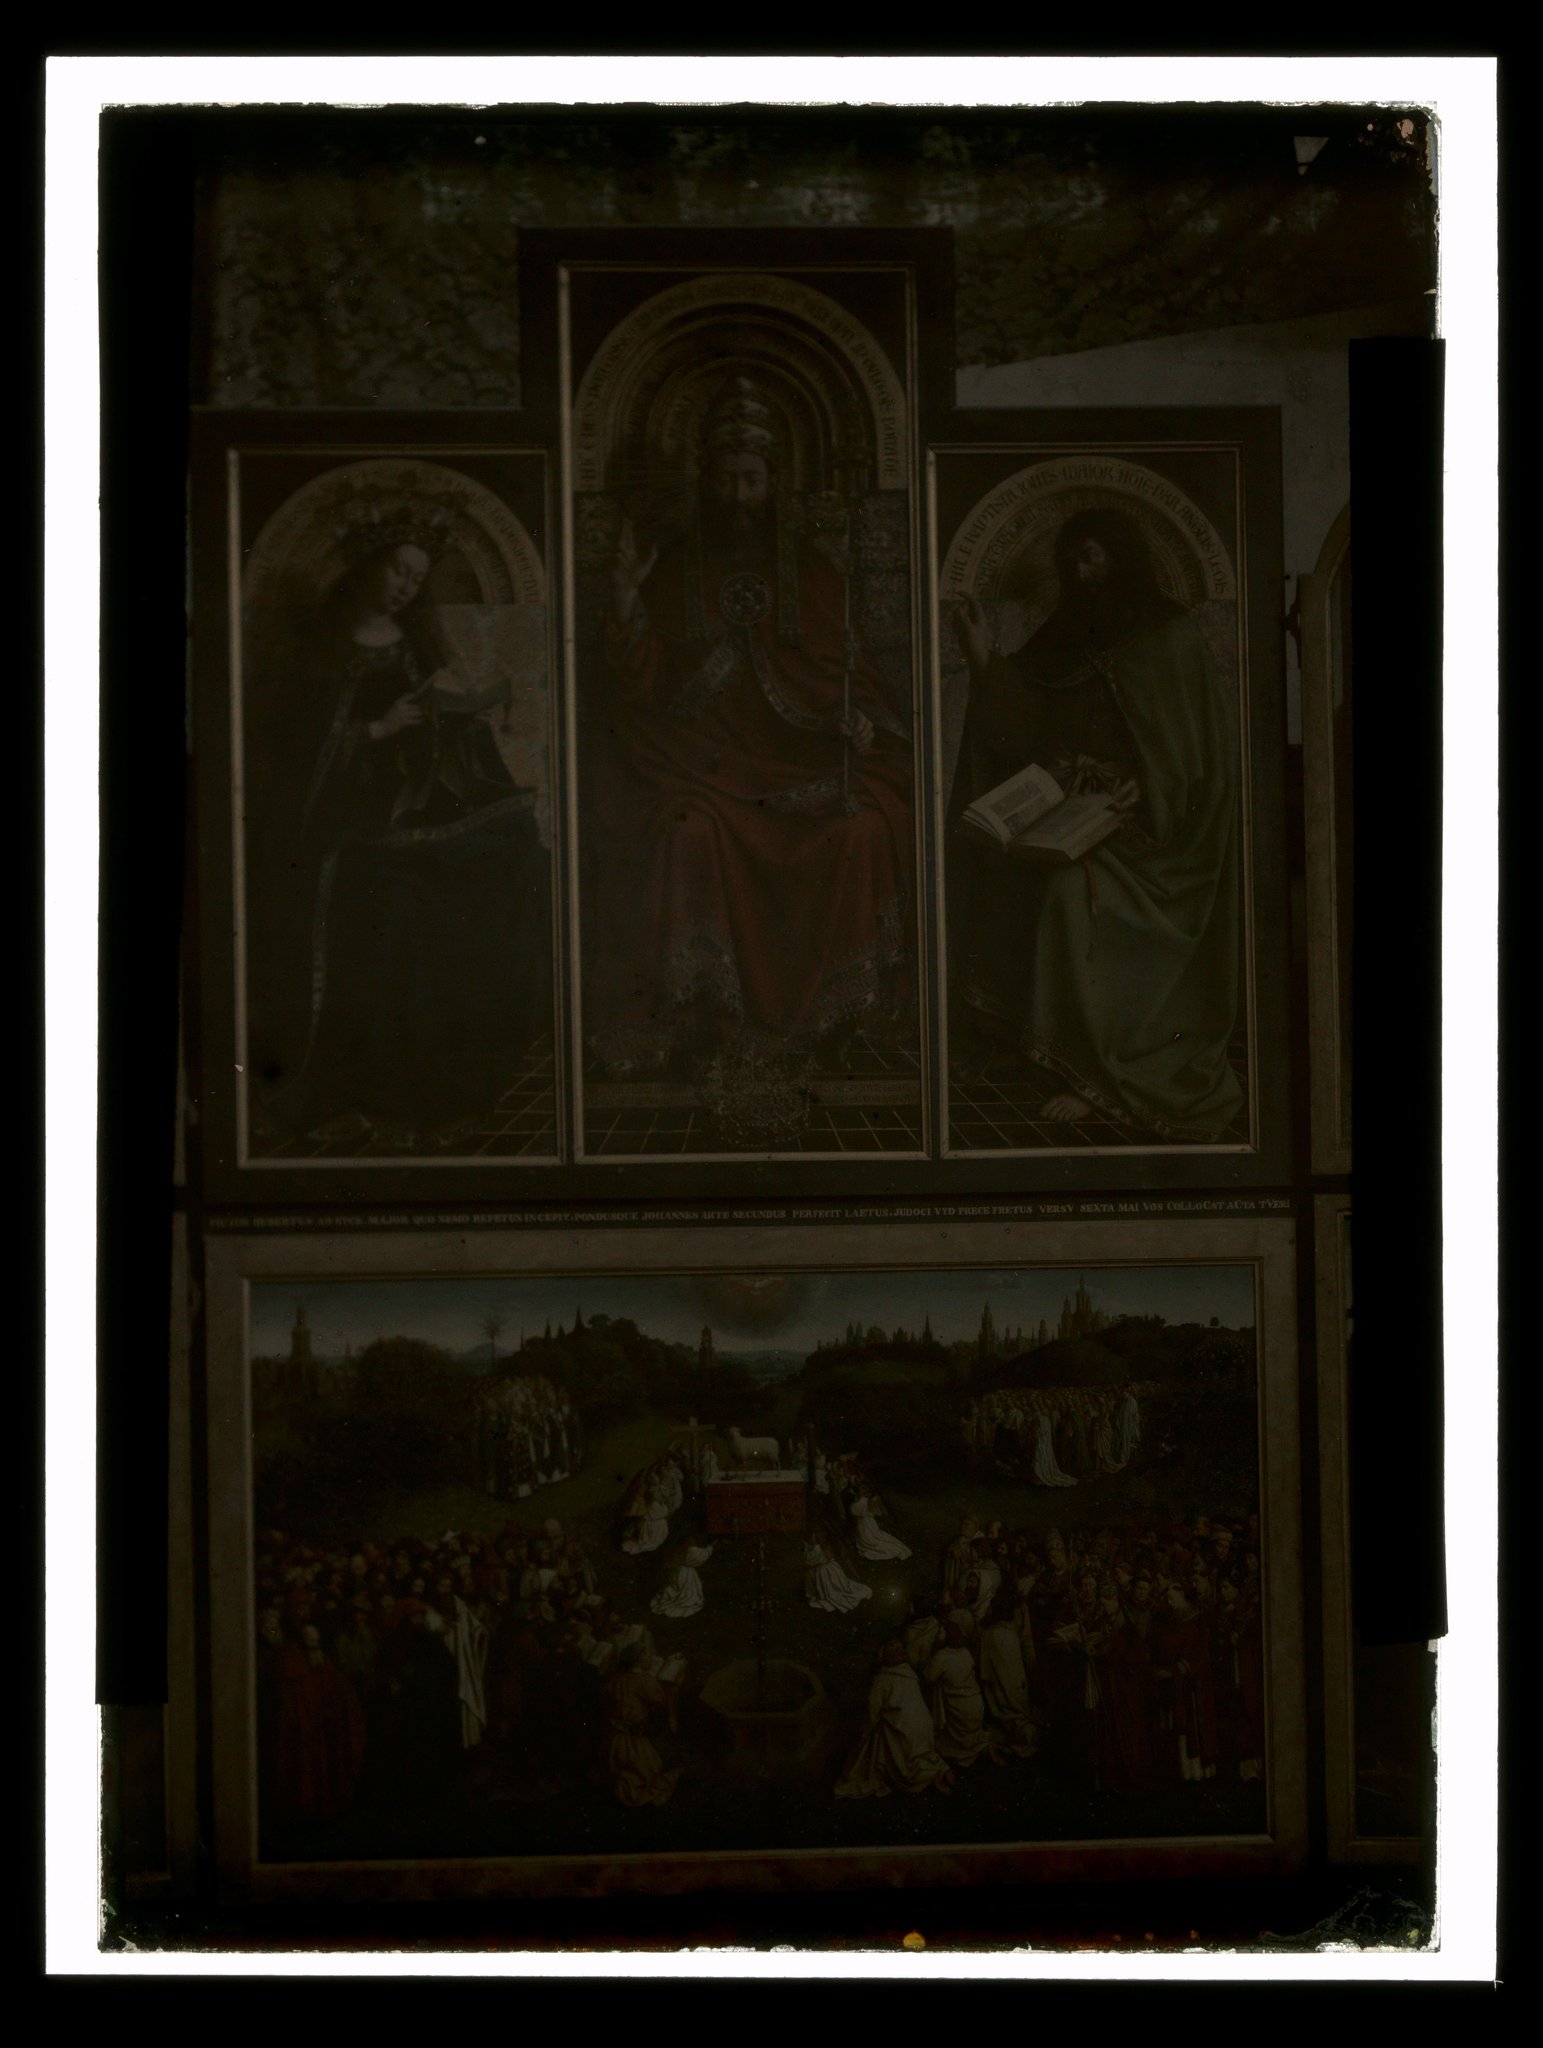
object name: photograph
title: Reproductie (autochroom) van het altaarstuk De aanbidding van het Lam Gods door Hubert en Jan van Eyck, opgesteld in de Sint-Baafskathedraal, Gent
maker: Anonymous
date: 1934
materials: cardboard, glass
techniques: autochrome process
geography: ghent